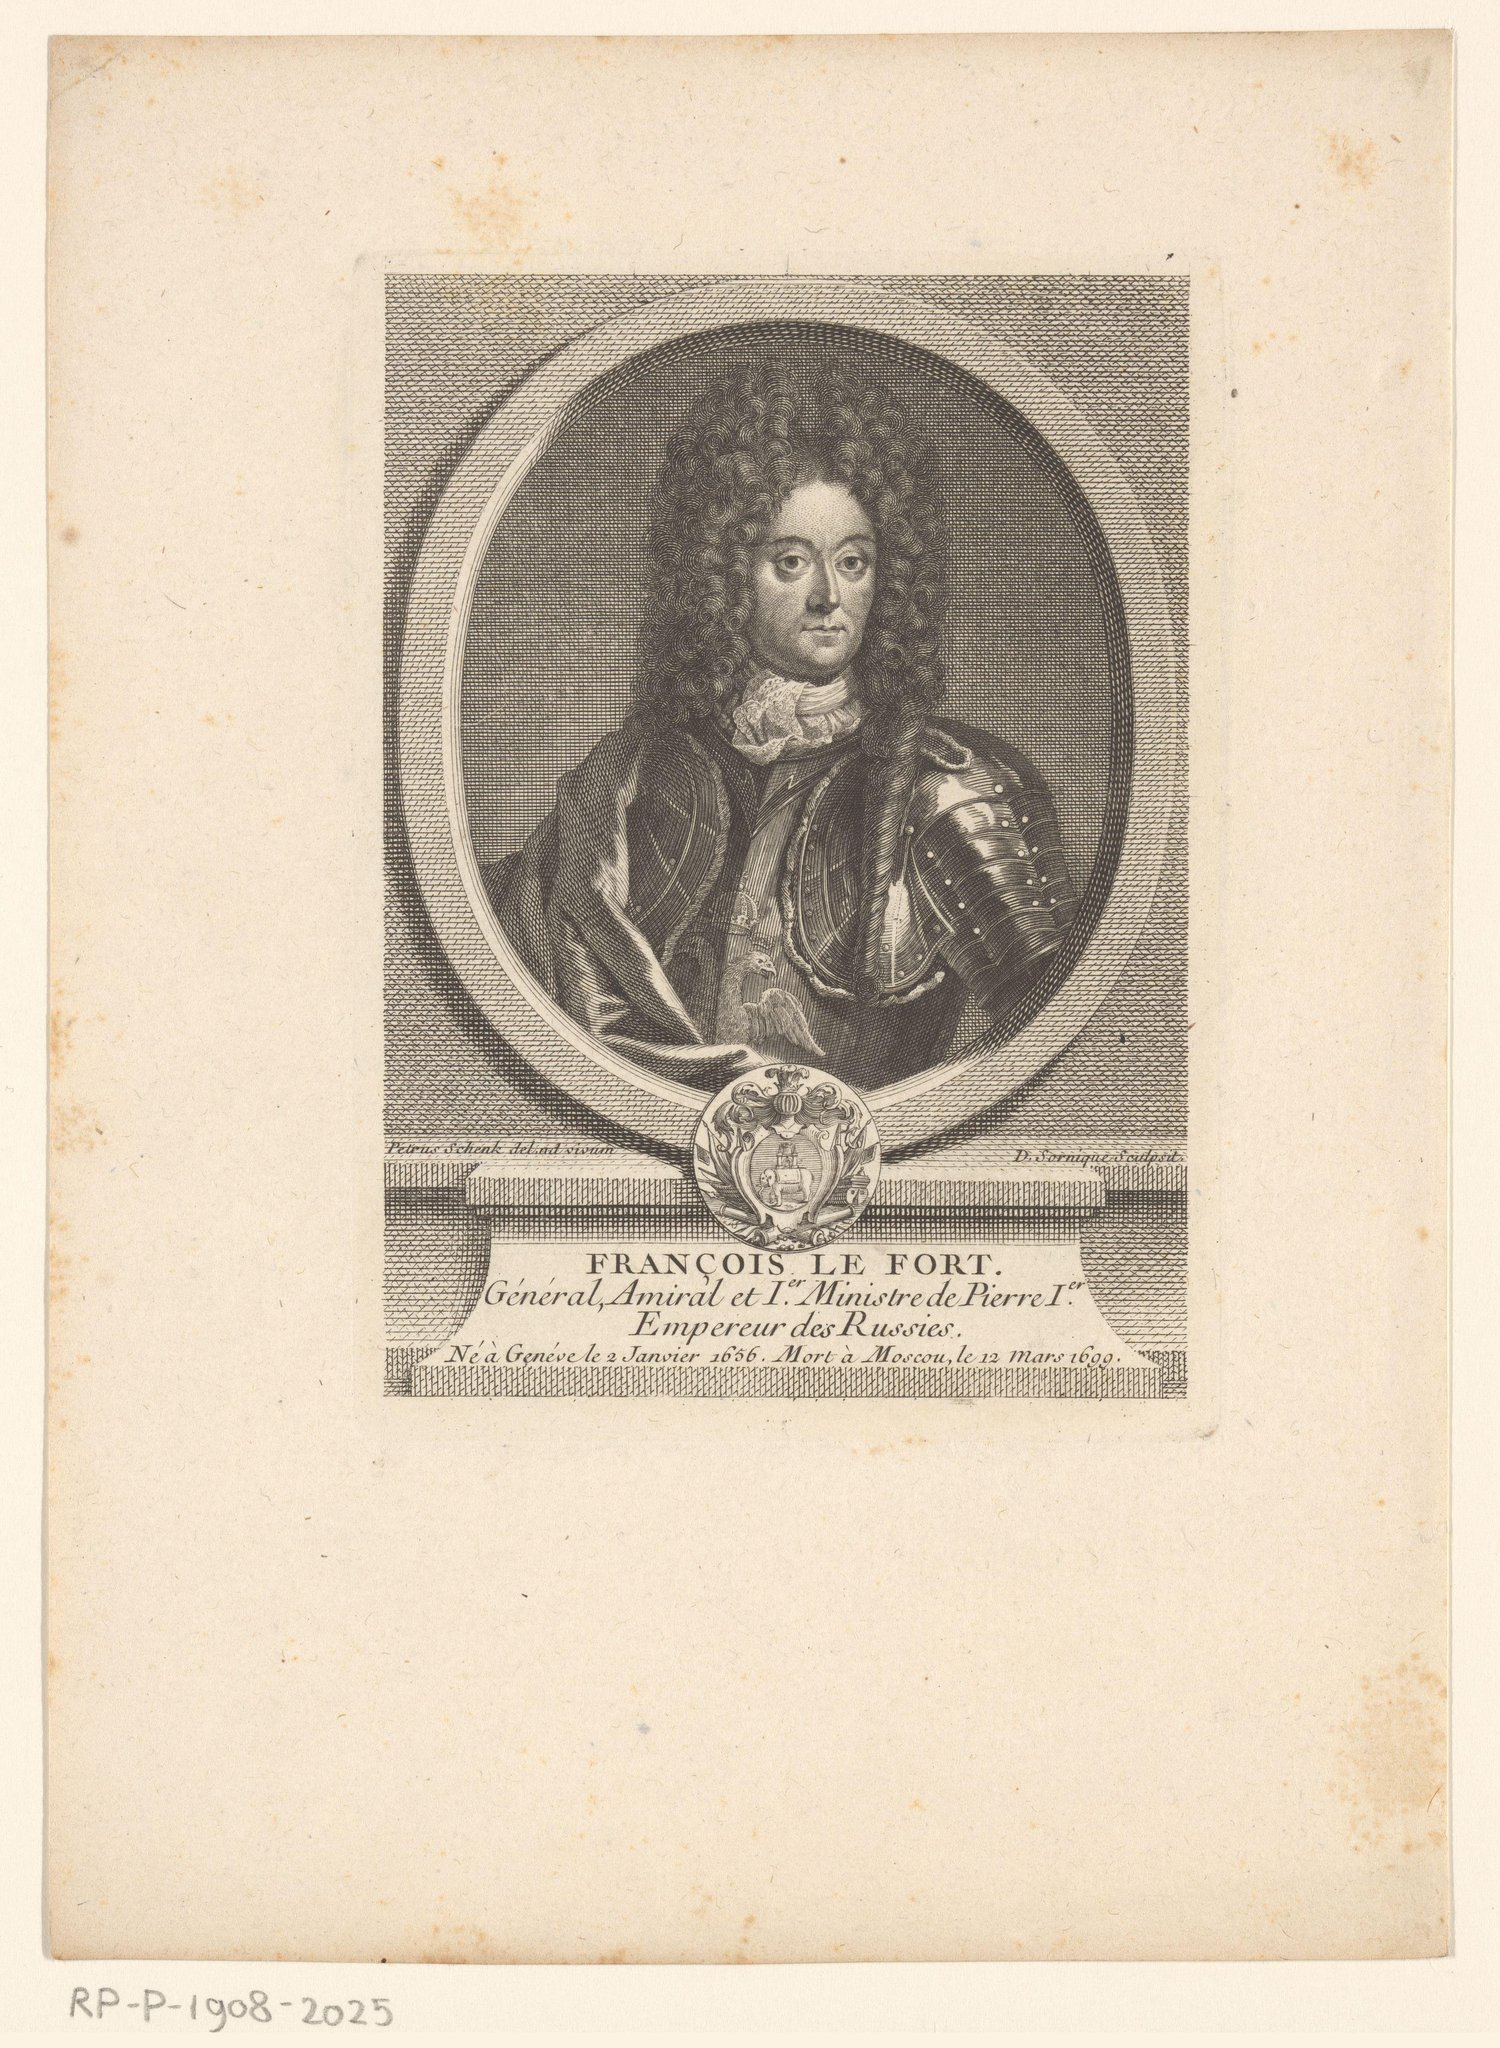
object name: book illustration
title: Portret van François Lefort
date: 1755-1765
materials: paper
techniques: engraving, etching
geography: paris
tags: historical persons, emperor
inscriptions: collector's mark: Lugt 2228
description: Prent uit: Dreux du Radier, Jean-François. L'Europe illustré, contenant l'histoire abregée des souverains, des princes, des prélats, des ministres, (...) en Europe: dans le XVe. siècle compris, jusqu'à présent. Parijs: Michel Odieuvre en André-François Le Breton, 1755-1765.